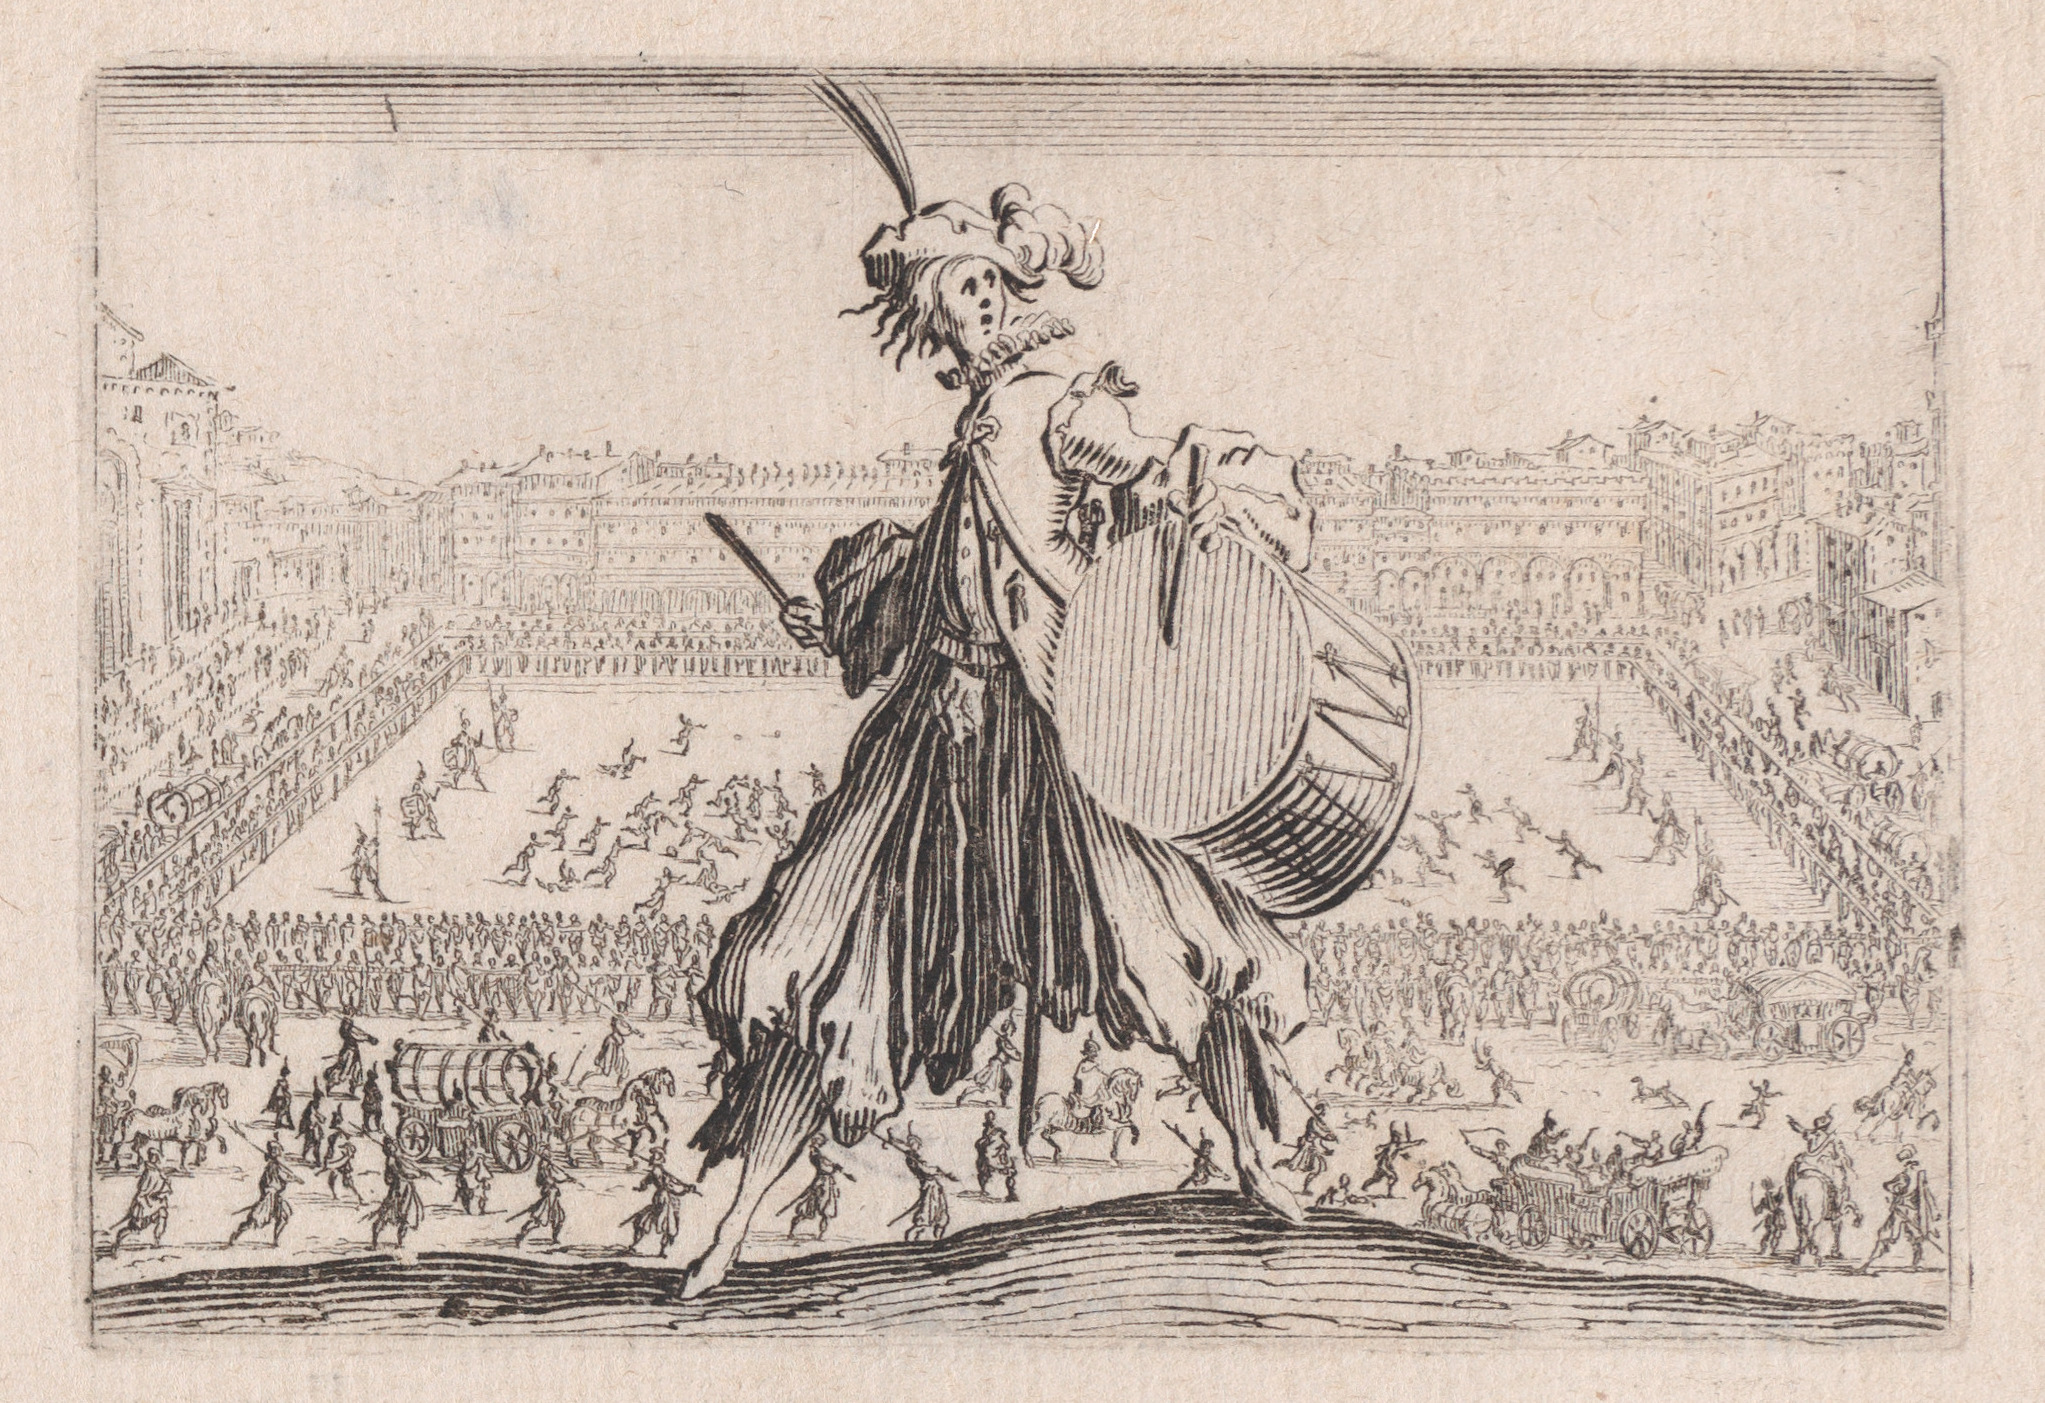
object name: print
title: Le Jeu de Paume sur la Place Sainte-Croix, a Florence (The Tennis Game on the Piazza Santa Croce in Florence), from "Les Caprices" Series B, The Nancy Set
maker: jacques callot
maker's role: artist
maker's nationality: french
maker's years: 1592-1635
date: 1617-1620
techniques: etching